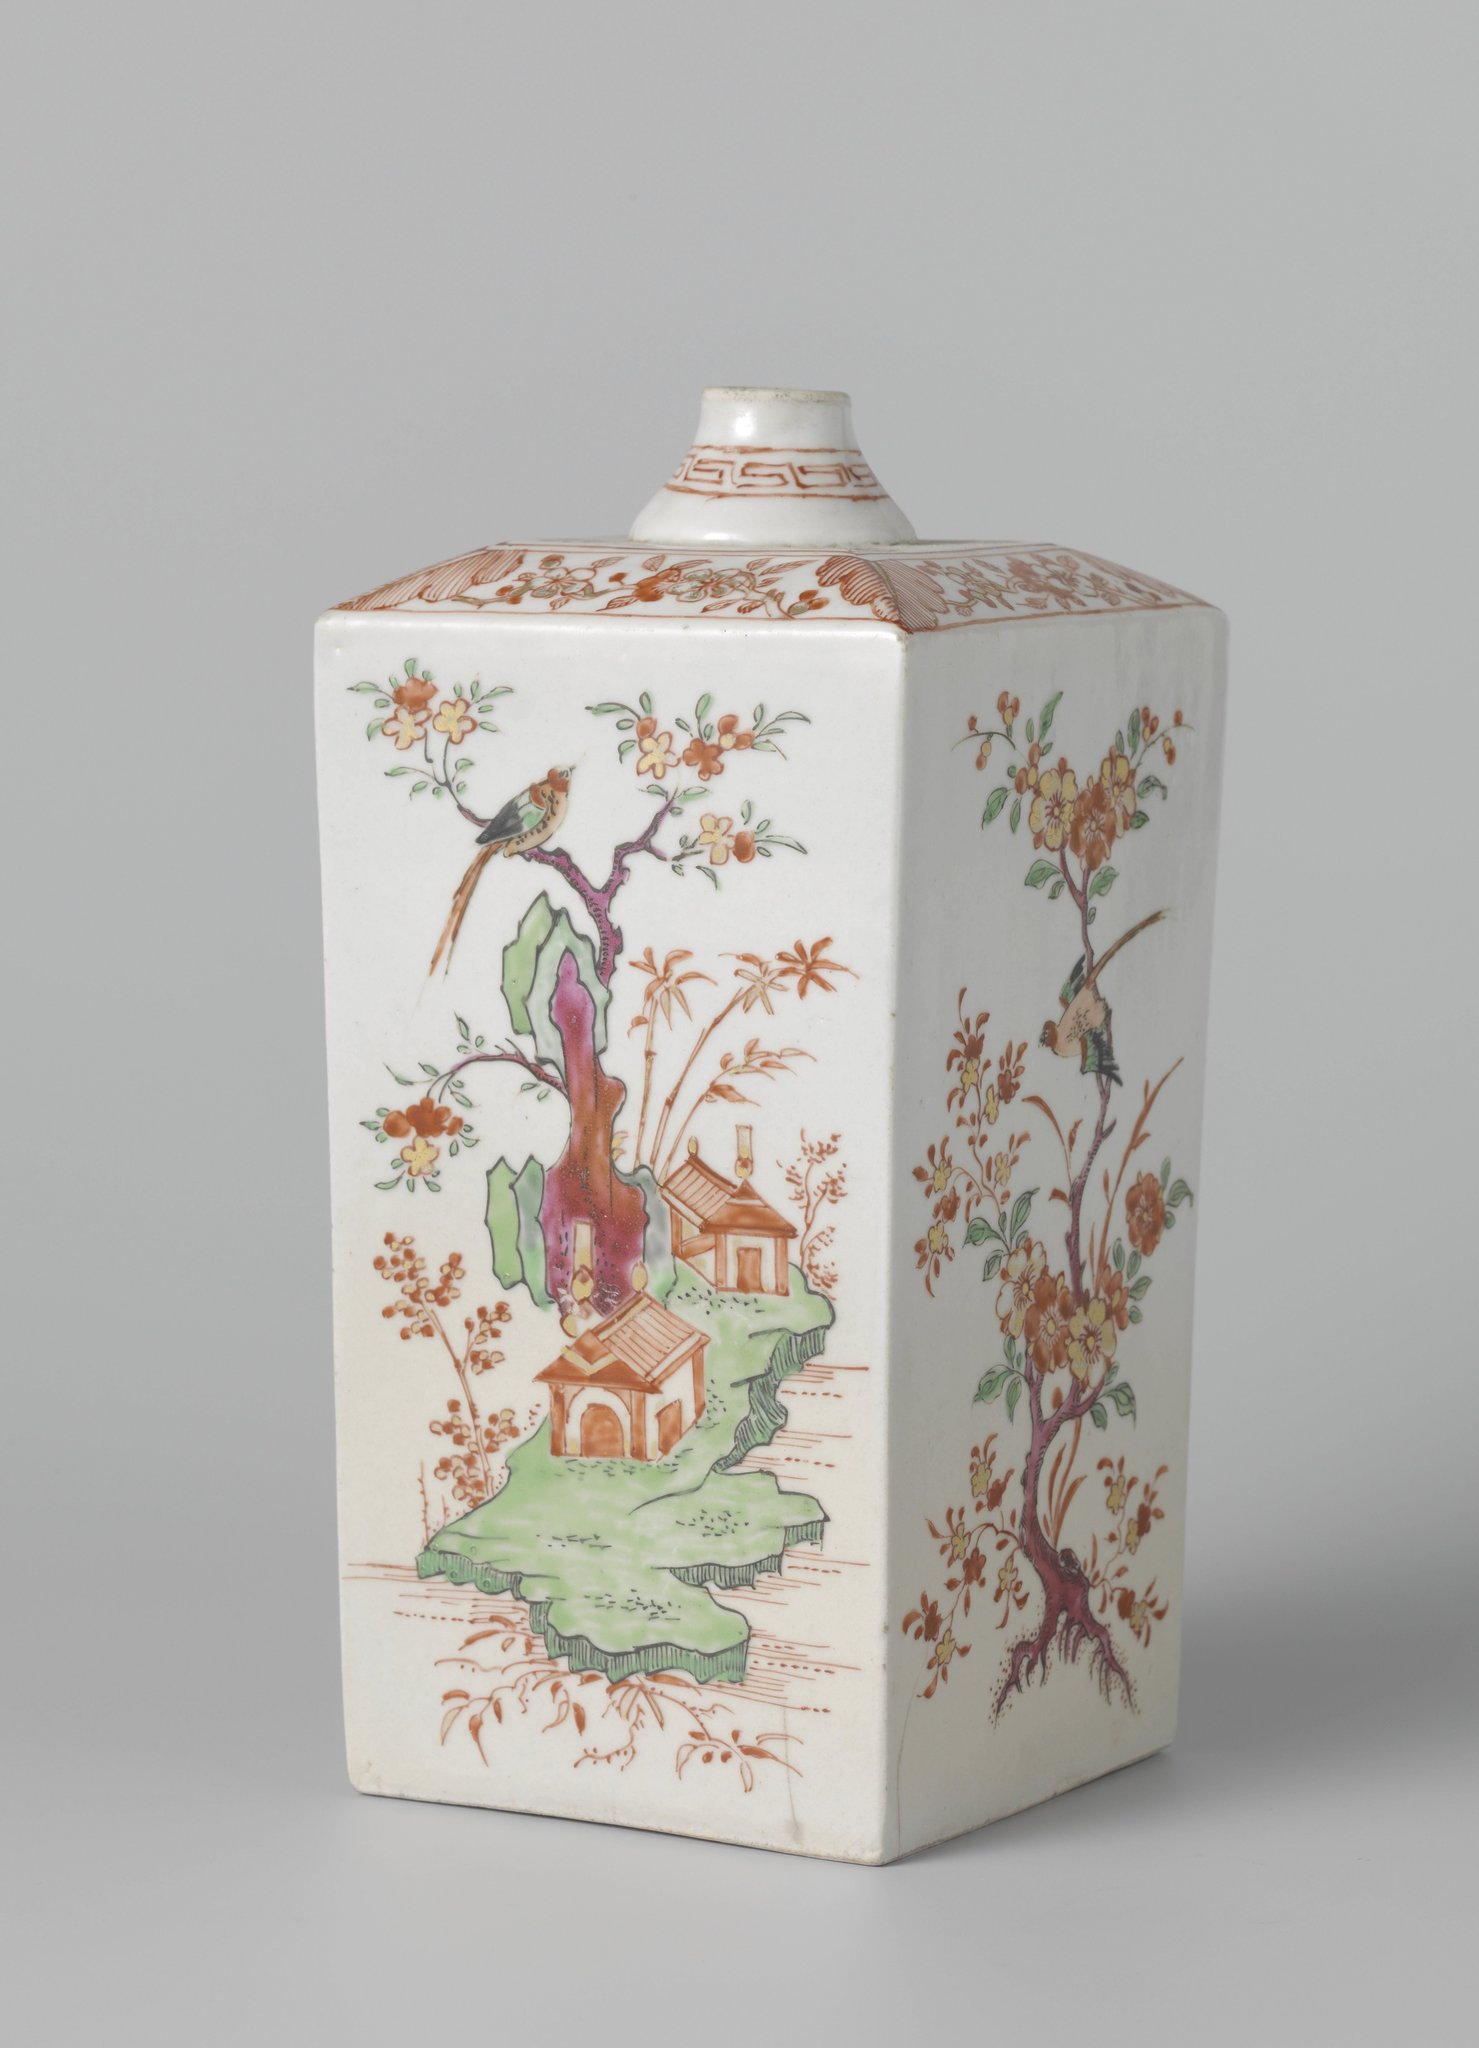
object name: bottle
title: Square bottle with birds, flowering plants and pavilions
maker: Anonymous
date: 1700-1724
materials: bronze, glaze, gold, paint, porcelain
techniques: firing, forming, gilding, vitrification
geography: japan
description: Vierkante fles van porselein met een verguld, bronzen dop, beschilderd op het glazuur in rood, groen, geel, paars, zwart en goud. Op de wanden tweemaal paviljoens op een eiland met rotsen en bloeiende planten (bamboe), een vogel op een tak, en tweemaal een vliegende vogel bij een prunustak en bamboe. Op de schouder een band met prunustakken en een bladmotief; rond de hals ranken. Op de hals een meanderpatroon. De dop is in de vorm van een gevlochten ring, eindigend in een hoo-vogelkop op een bloemrozet. De rand is afgeslepen. Arita, in Europa gedecoreerd[?] in de Japanse Kakiemon-stijl.